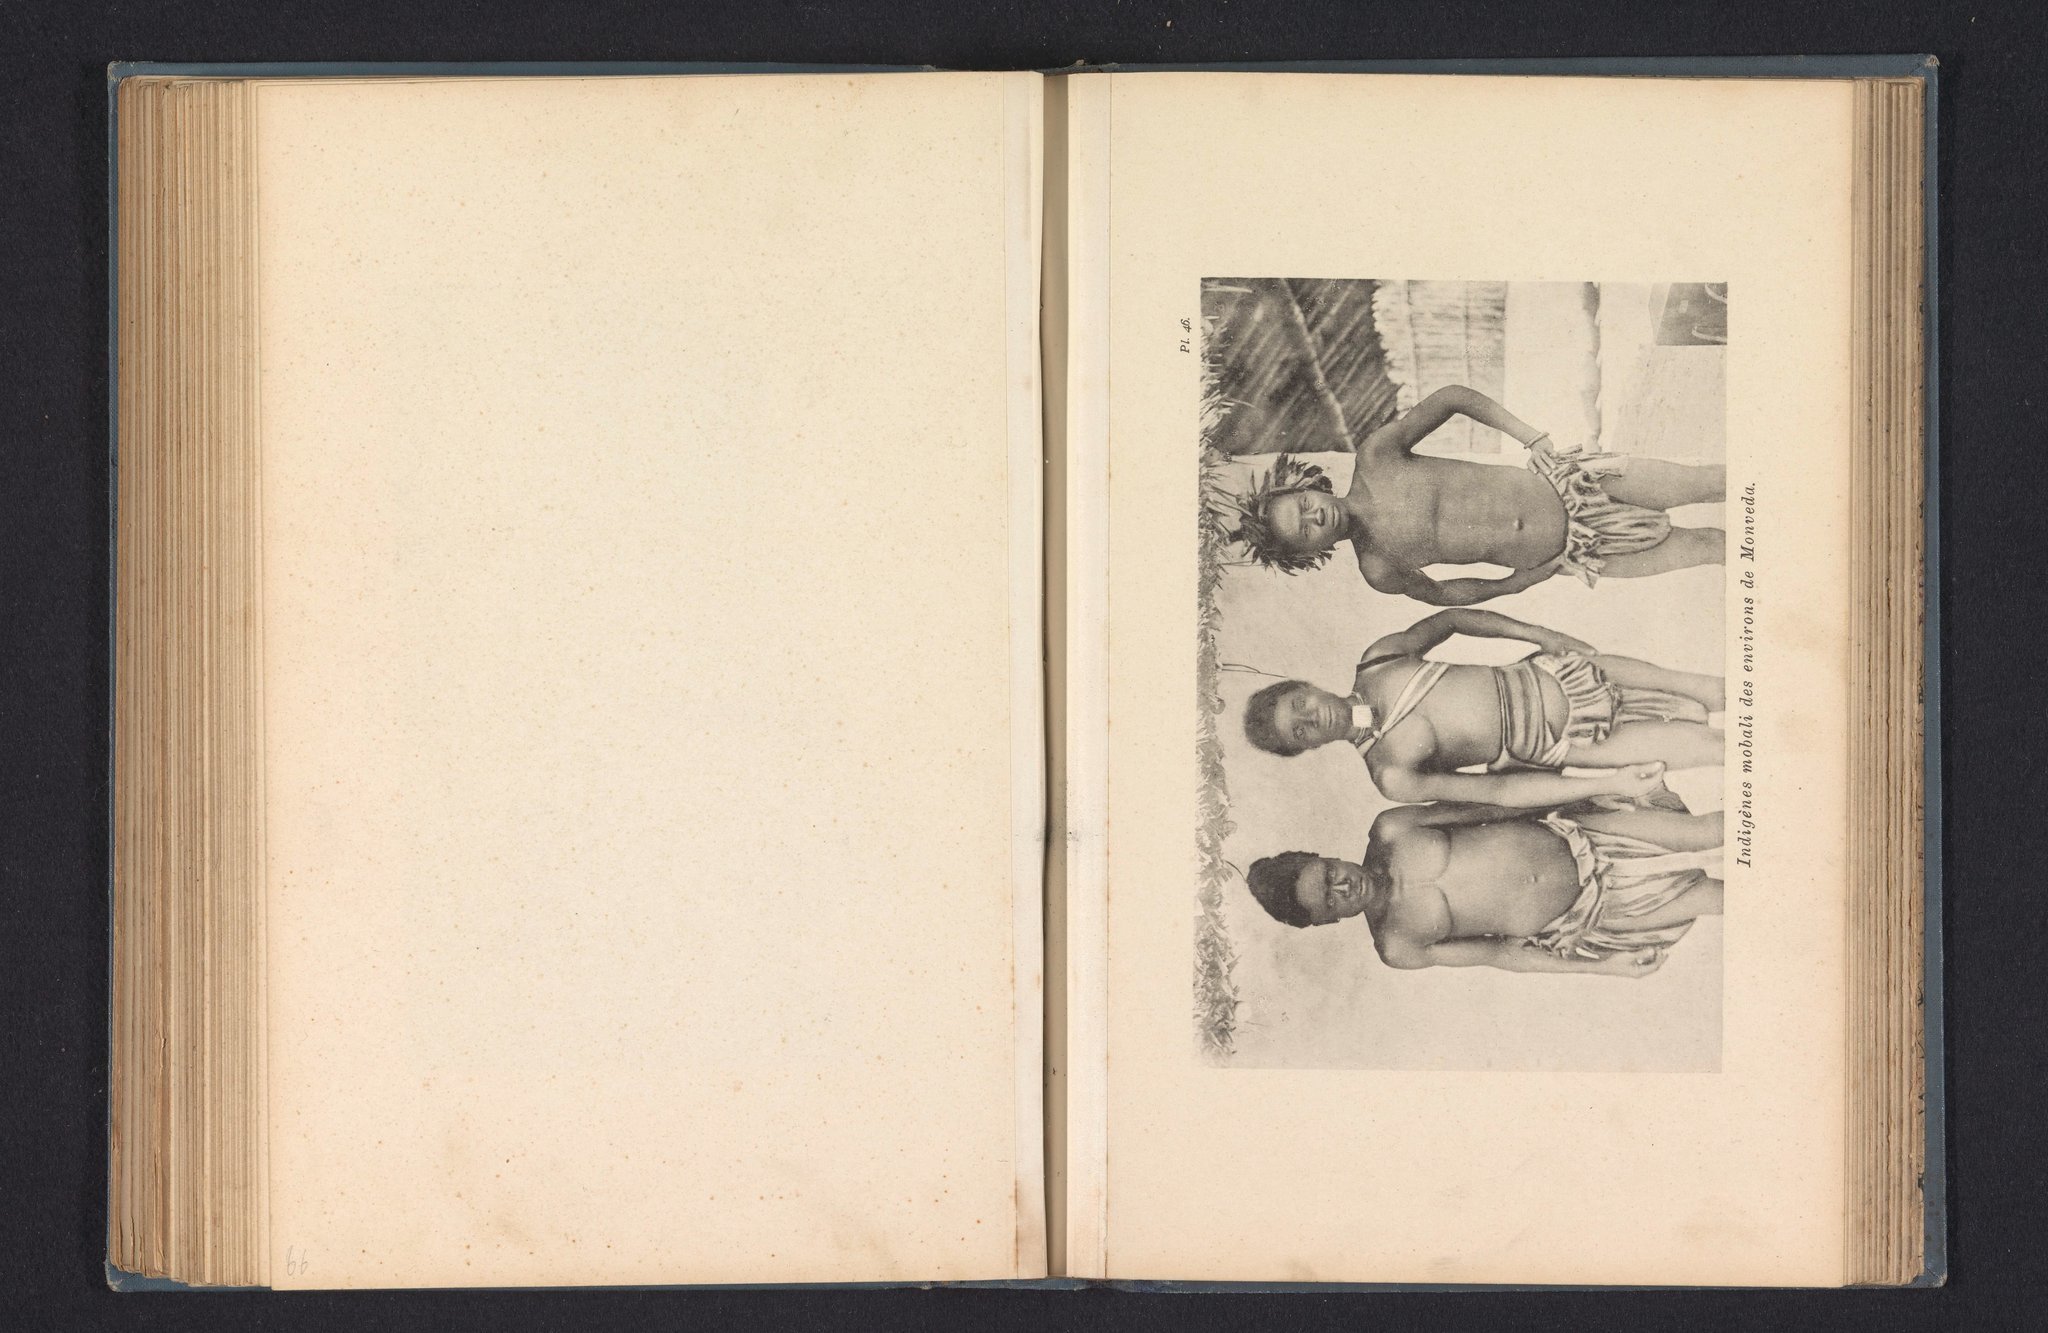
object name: page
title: Portret van drie mannen van de Mobali nabij Monveda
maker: franz thonner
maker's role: botanicus, ontdekkingsreiziger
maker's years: 1863-1928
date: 1896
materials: paper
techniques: photograph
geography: dresden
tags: adult man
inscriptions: number: ‘Pl. 46.’